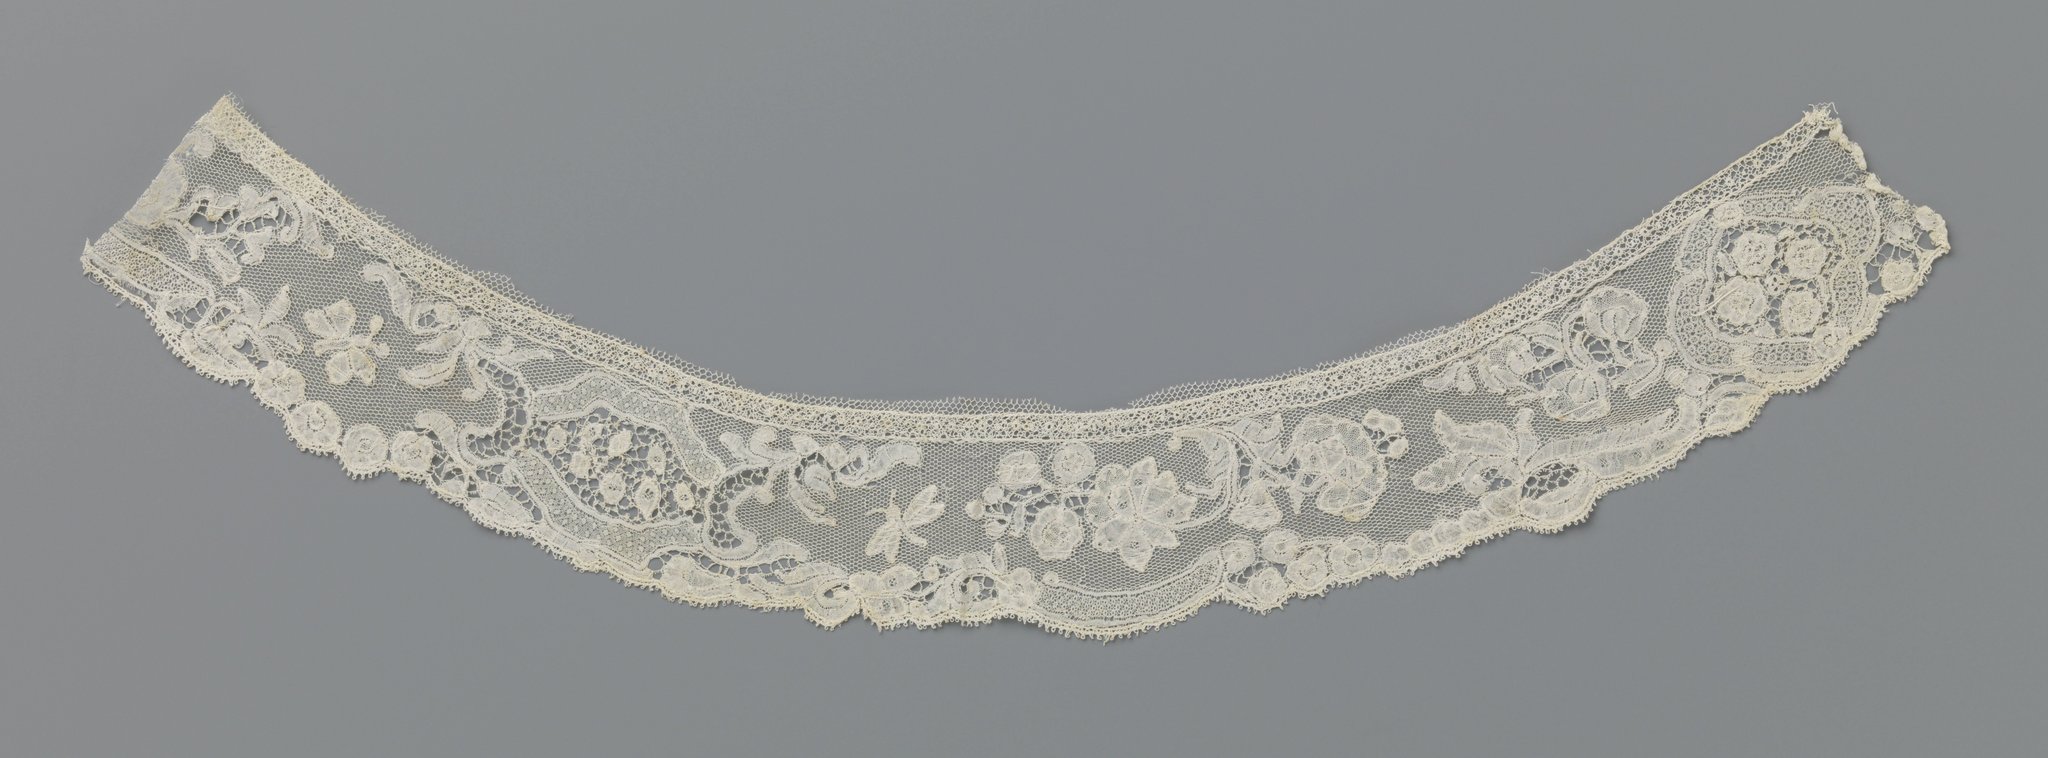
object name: strip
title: Strook kloskant met bloemtak en insect tussen twee cartouches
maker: Anonymous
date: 1735-1750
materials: linen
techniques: lace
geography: brussels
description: Strook naturelkleurige Brusselse kloskant. De strook is iets gebogen van vorm. Het patroon bestaat uit een hangende bloemtak en een vliegend insect tussen twee verschillende vormen cartouches. De motieven zijn met elkaar verbonden door een fijne maasgrond, een drochelgrond. Het volwerk is grotendeels gemaakt in linnenslag met opengewerkte randjes, enkele uitsparingen en met netslagvullingen. Verschillende motieven hebben gekloste reliëfcontouren. Er zijn verschillende siergronden toegepast, waaronder gepicoteerde vlechtengronden. De bovenzijde is afgewerkt met een apart geklost bandje, waaraan fragmentjes vastzitten van een zeshoekige maasgrond. De geschulpte onderzijde is afgewerkt met picots.